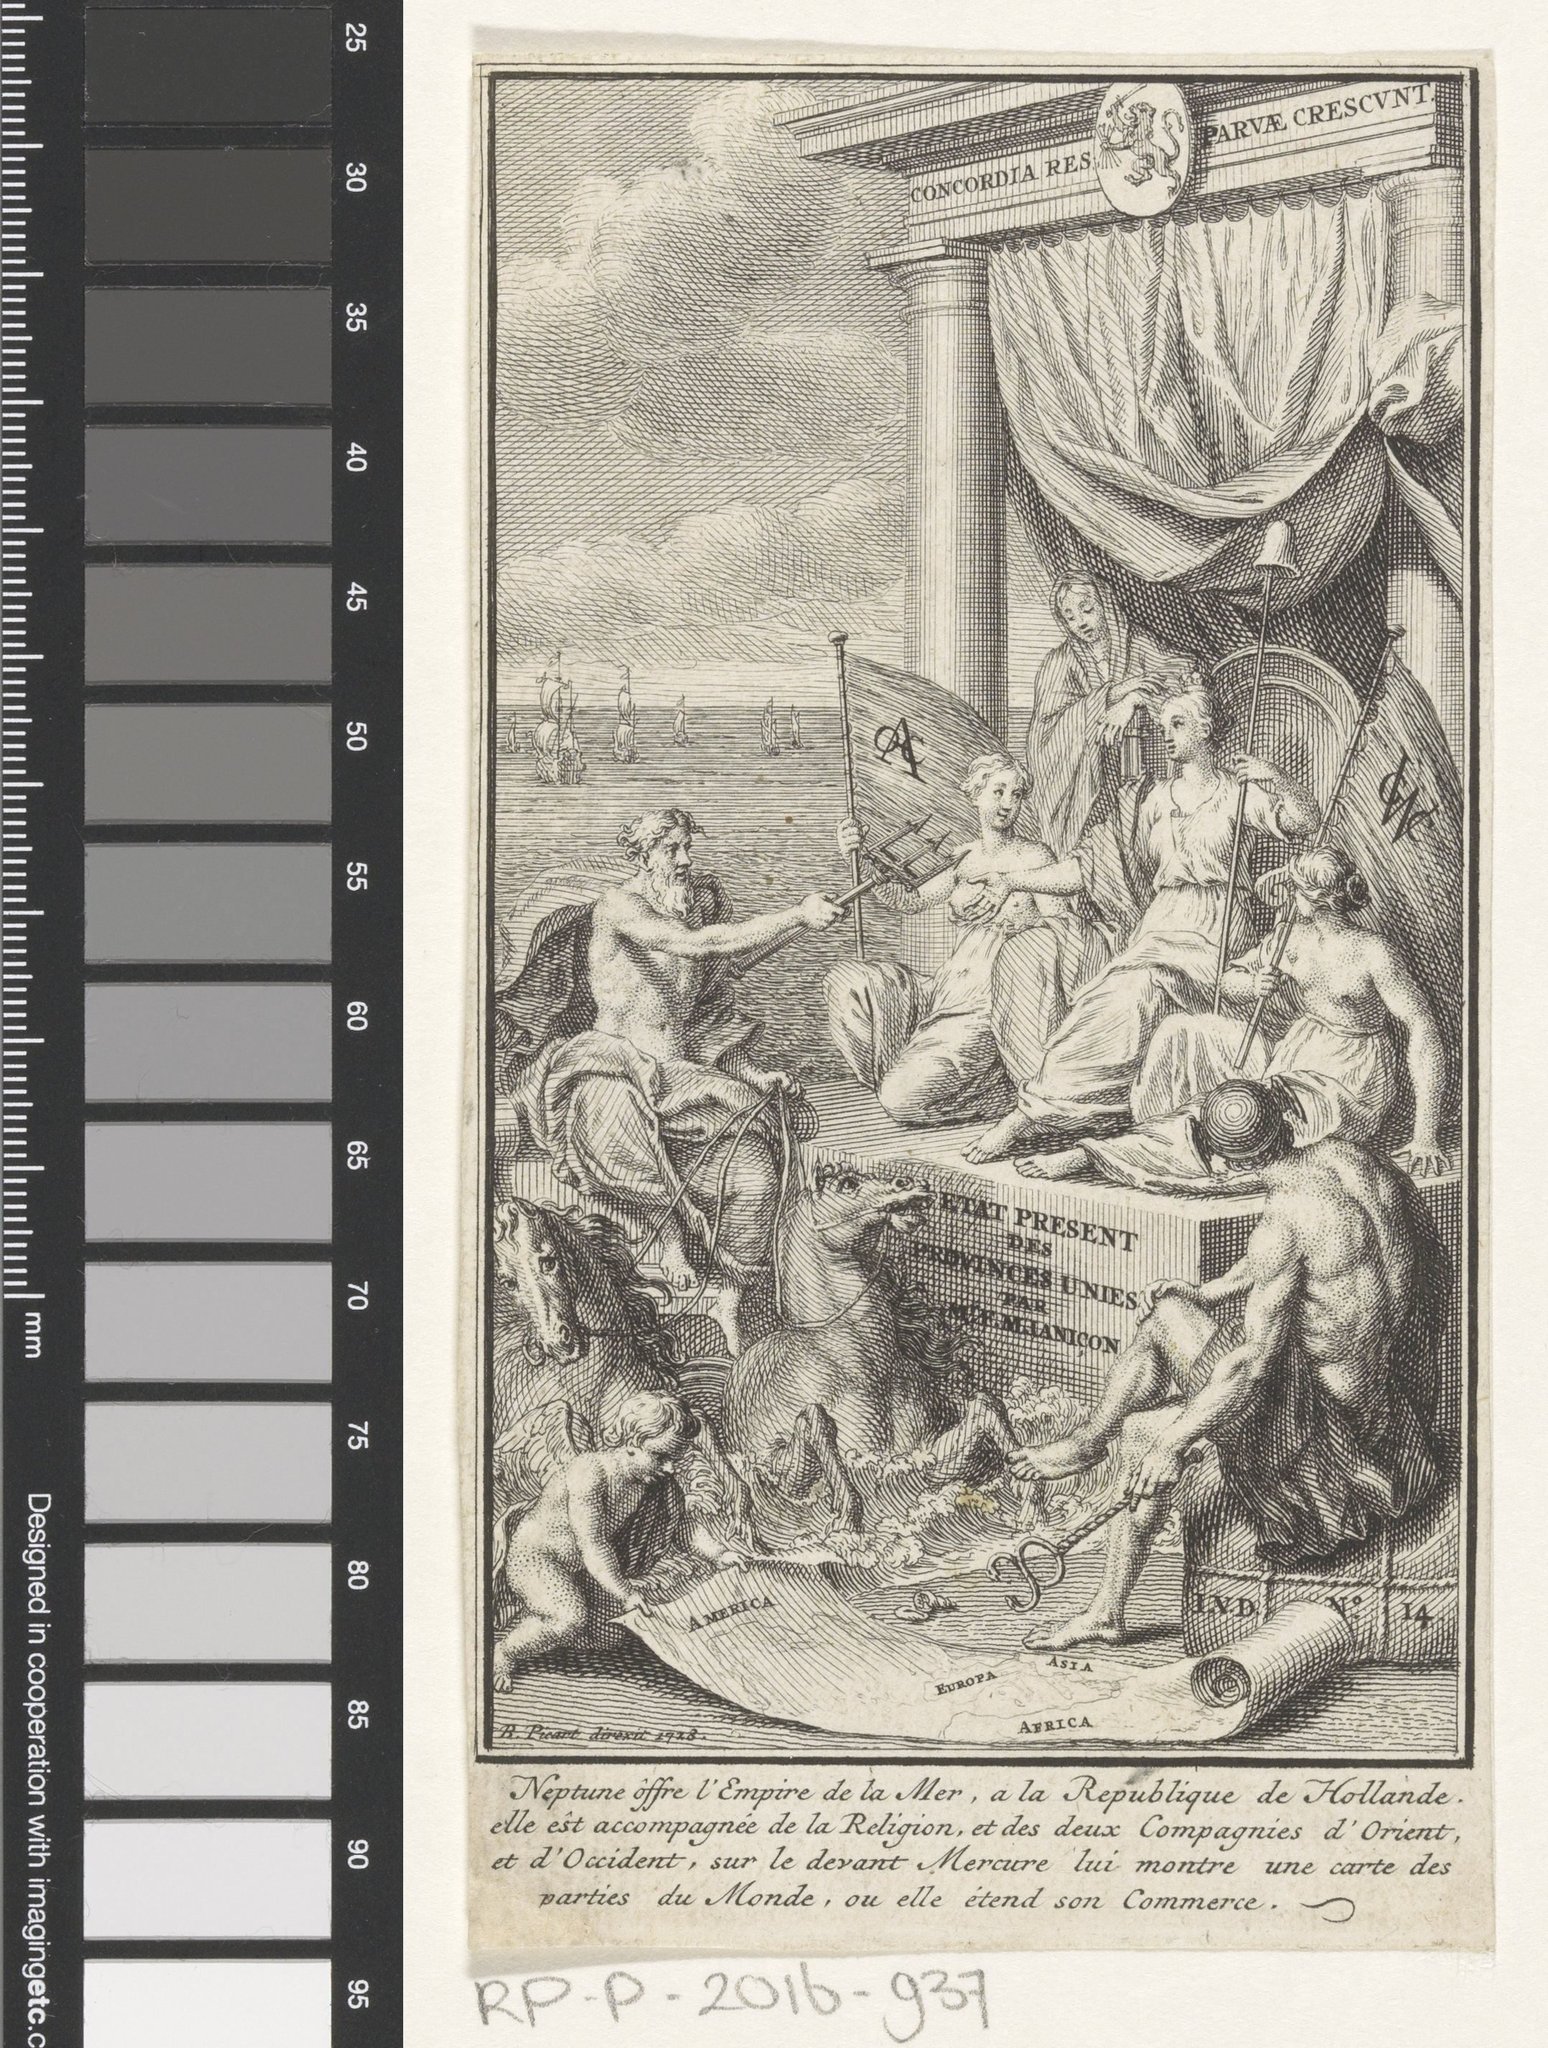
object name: print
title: Allegorie op de macht van de Republiek der Zeven Verenigde Nederlanden als zeemogenheid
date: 1728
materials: paper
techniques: engraving, etching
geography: the hague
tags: (story of) neptune (poseidon), personifications of countries, nations, states, districts, etc., (story of) mercury (hermes), map of the world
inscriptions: collector's mark: Lugt 2228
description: Neptunus schenkt zijn drietand, die symbool staat voor de overheersing op de wereldzeeën, aan de personificatie van de Republiek der Zeven Verenigde Nederlanden. Zij houdt in de hand een lans met vrijheidshoed en wordt omringd door de personificaties van de Oost-Indische Compagnie (VOC) en de West-Indische Compagnie (WIC). Rechts wijst Mercurius met zijn caduceus op de wereldkaart die door een putto wordt uitgerold. In de ondermarge een vierregelige Franse tekst.